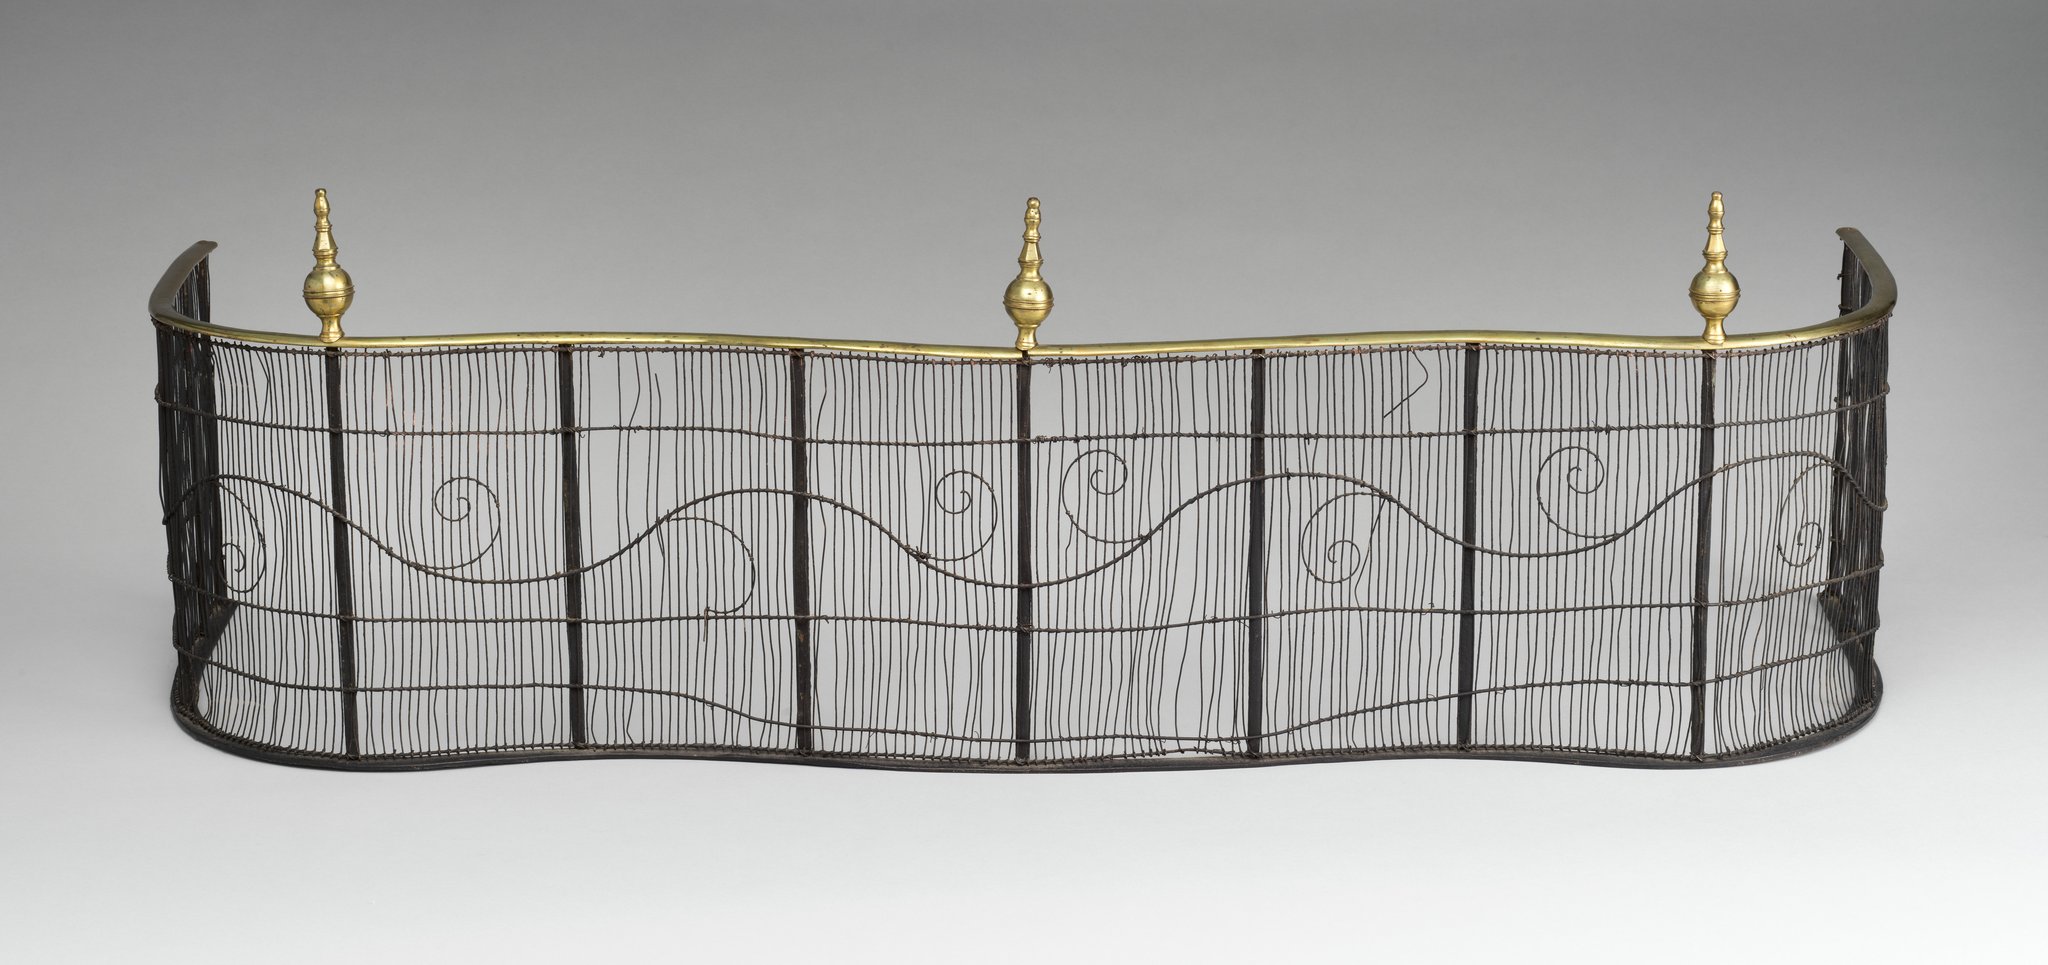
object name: fender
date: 1790-1815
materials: brass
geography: united states